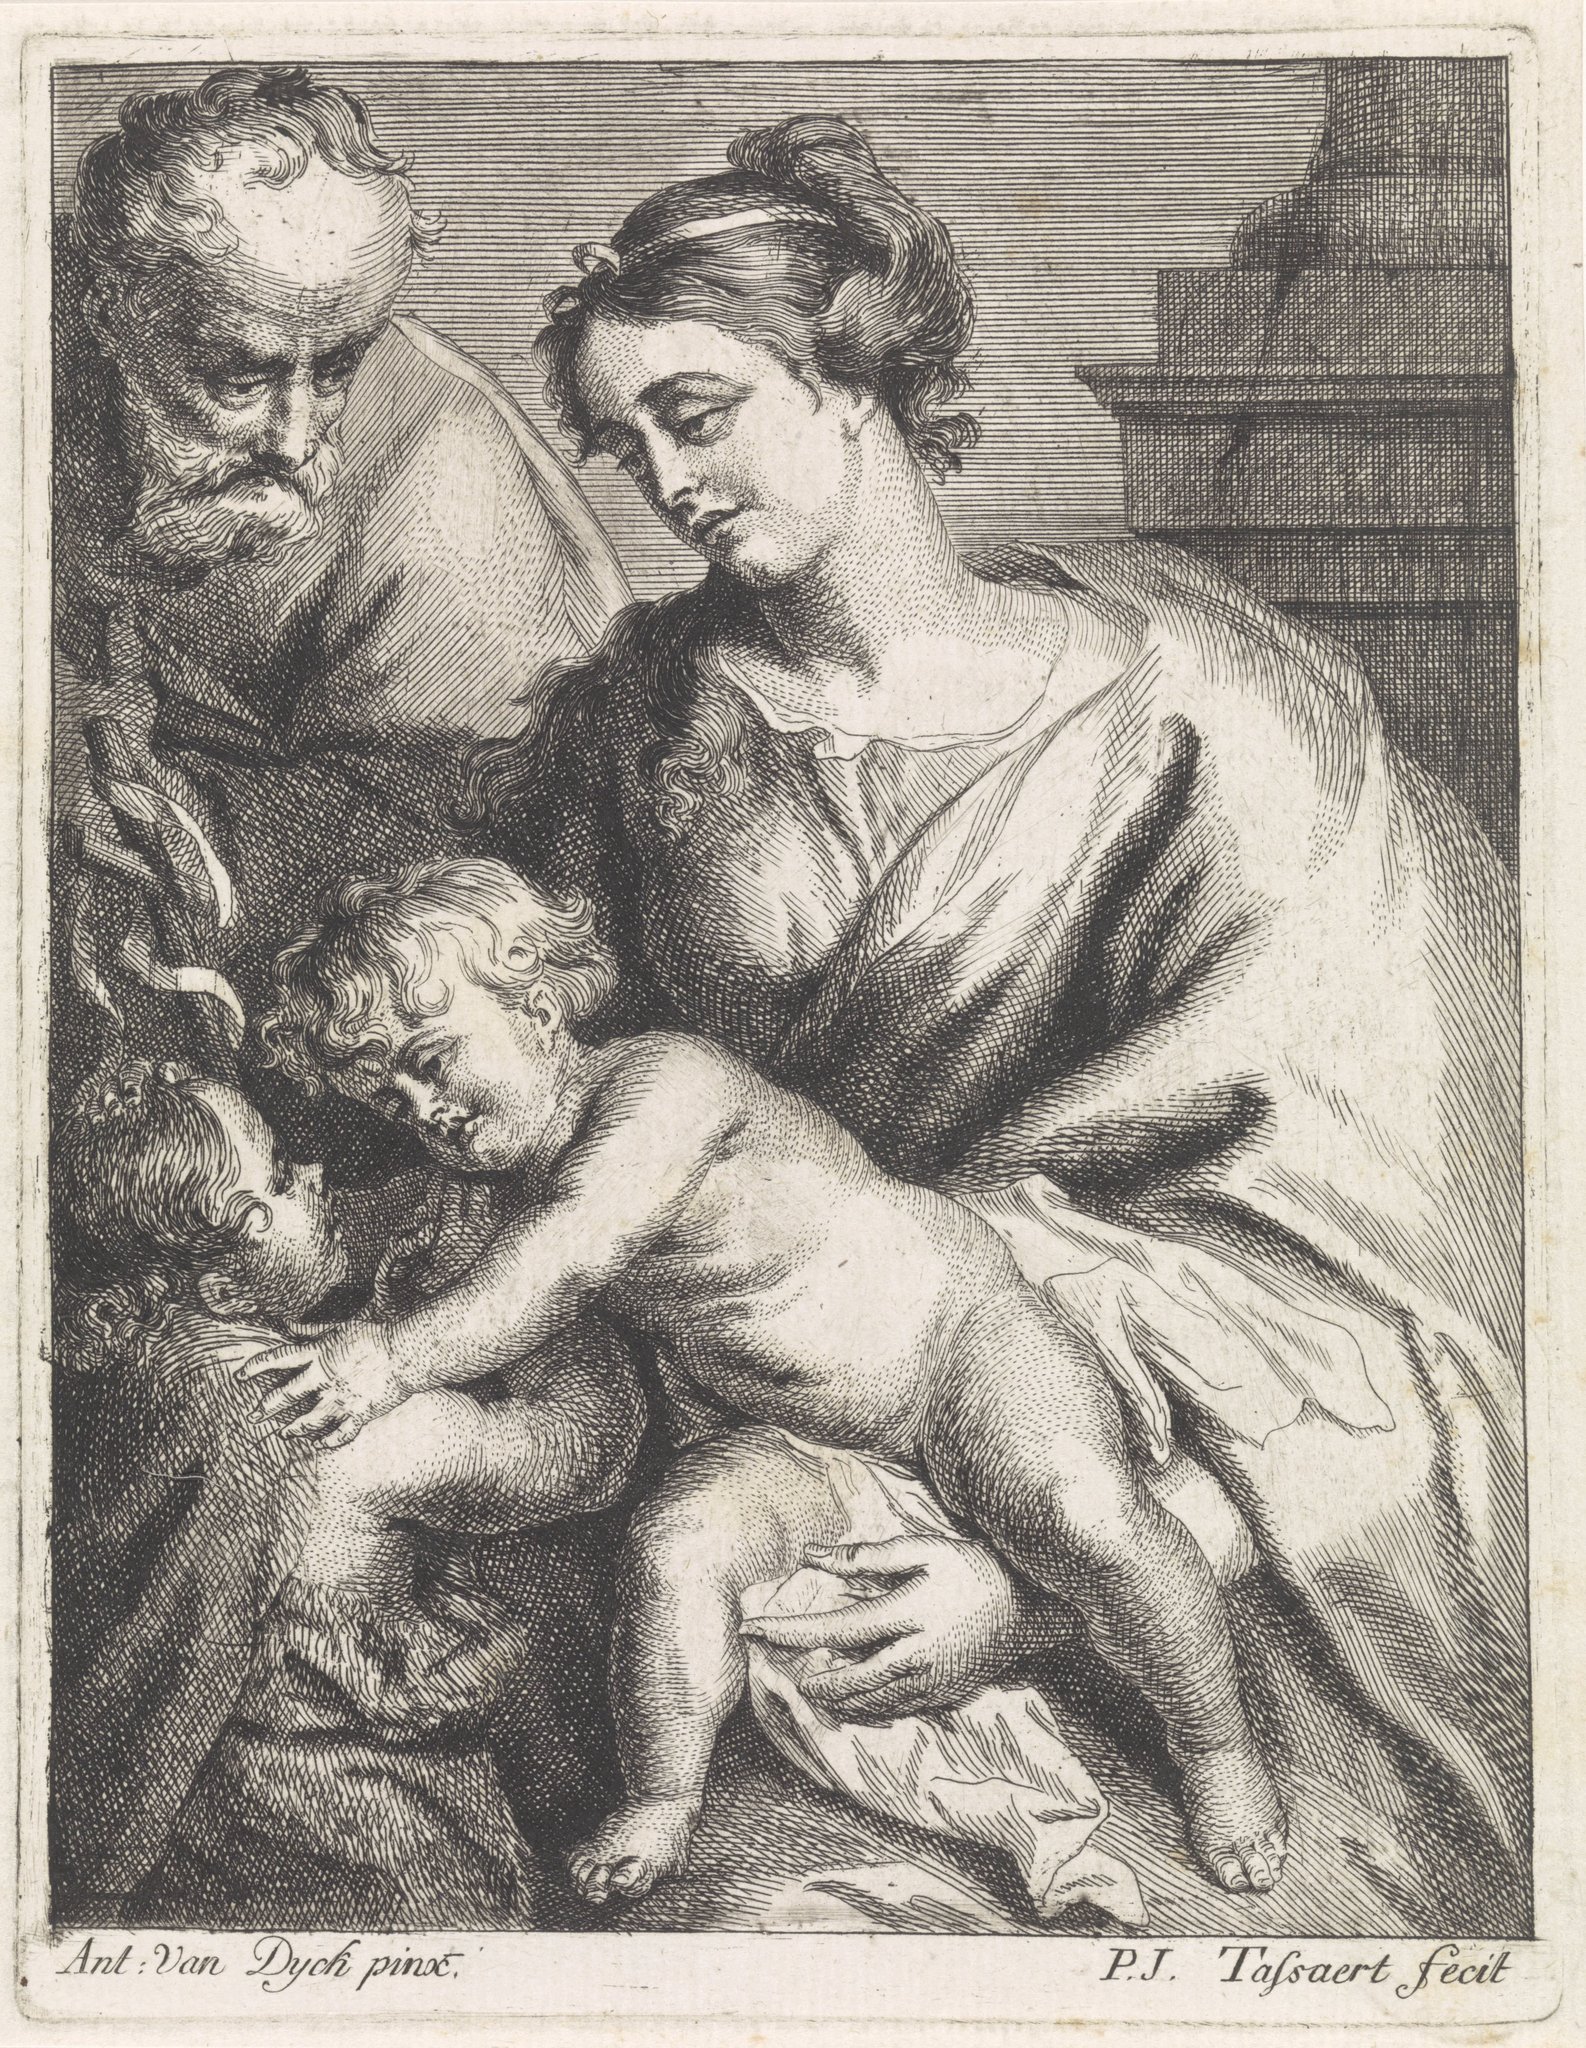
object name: print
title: Heilige Familie met Johannes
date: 1742-1803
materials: paper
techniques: etching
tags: holy family with john the baptist (as child)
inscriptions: collector's mark: Lugt 240